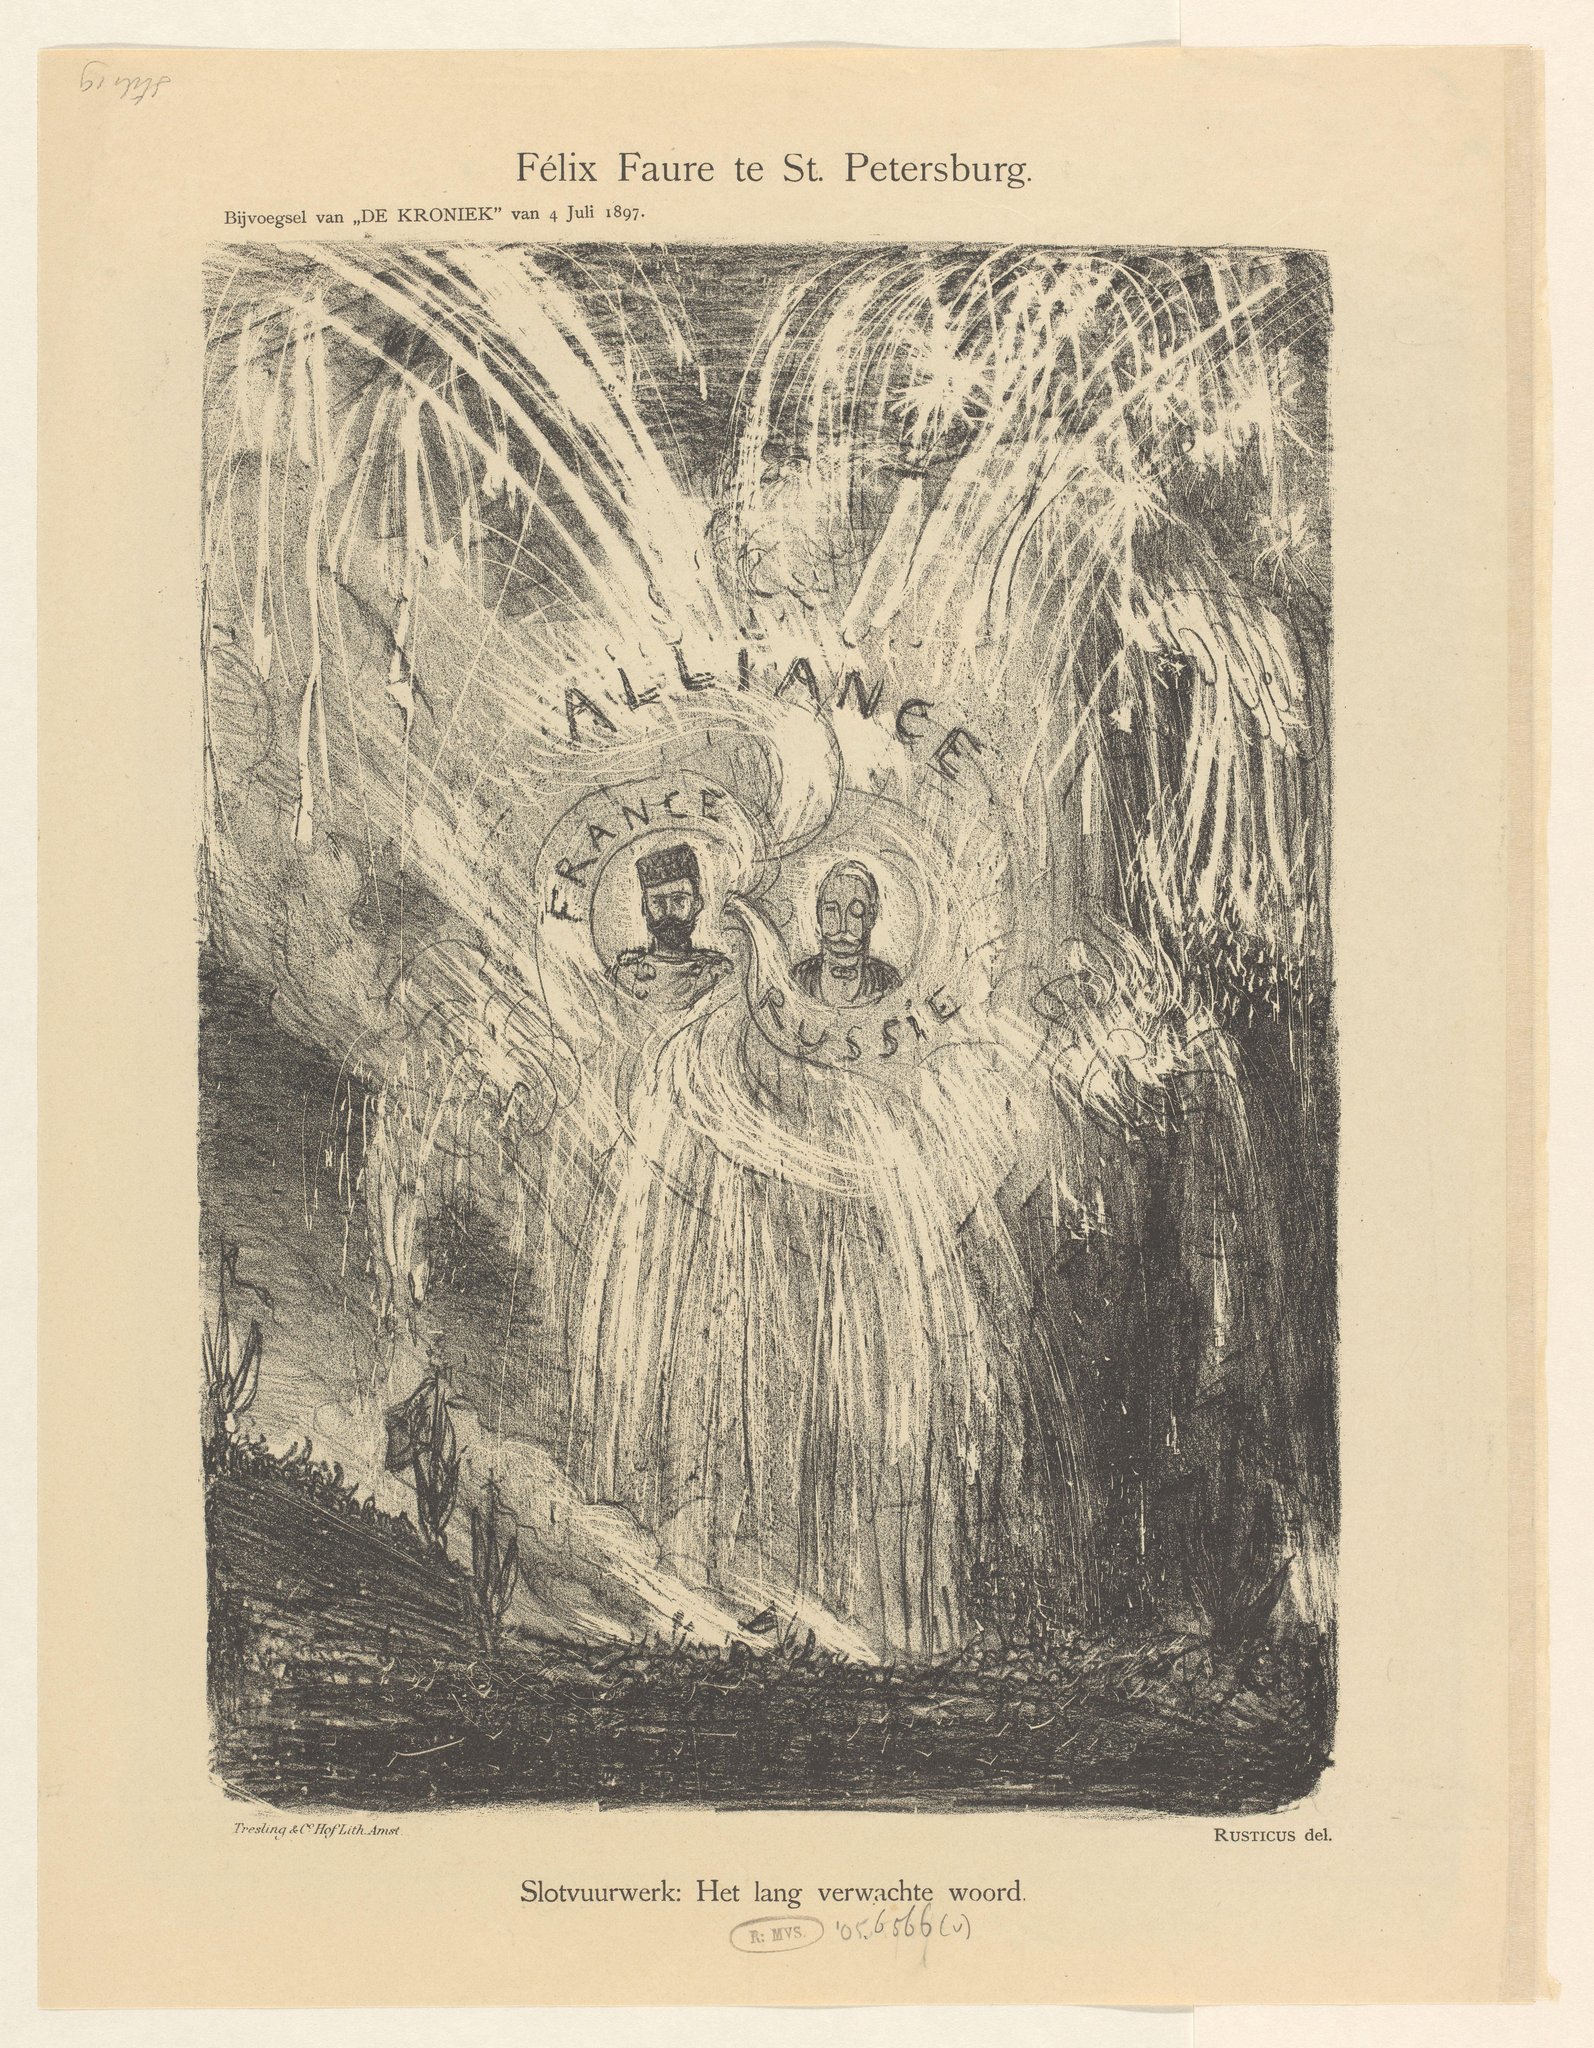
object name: cartoon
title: Félix Faure te St. Petersburg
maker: marius bauer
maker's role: draughtsman, print maker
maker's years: 1867-1932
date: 1897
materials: paper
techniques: lithograph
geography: amsterdam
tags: bonfire, fire-works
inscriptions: collector's mark: Lugt 2228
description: De Franse president Félix Faure is afgebeeld samen met Tsaar Nicolaas II te midden van vuurwerk. De prent werd uitgegeven naar aanleiding van het bezoek van Faure aan Sint-Petersburg. Deze prent was een bijvoegsel van De Kroniek van 4 juli 1897.